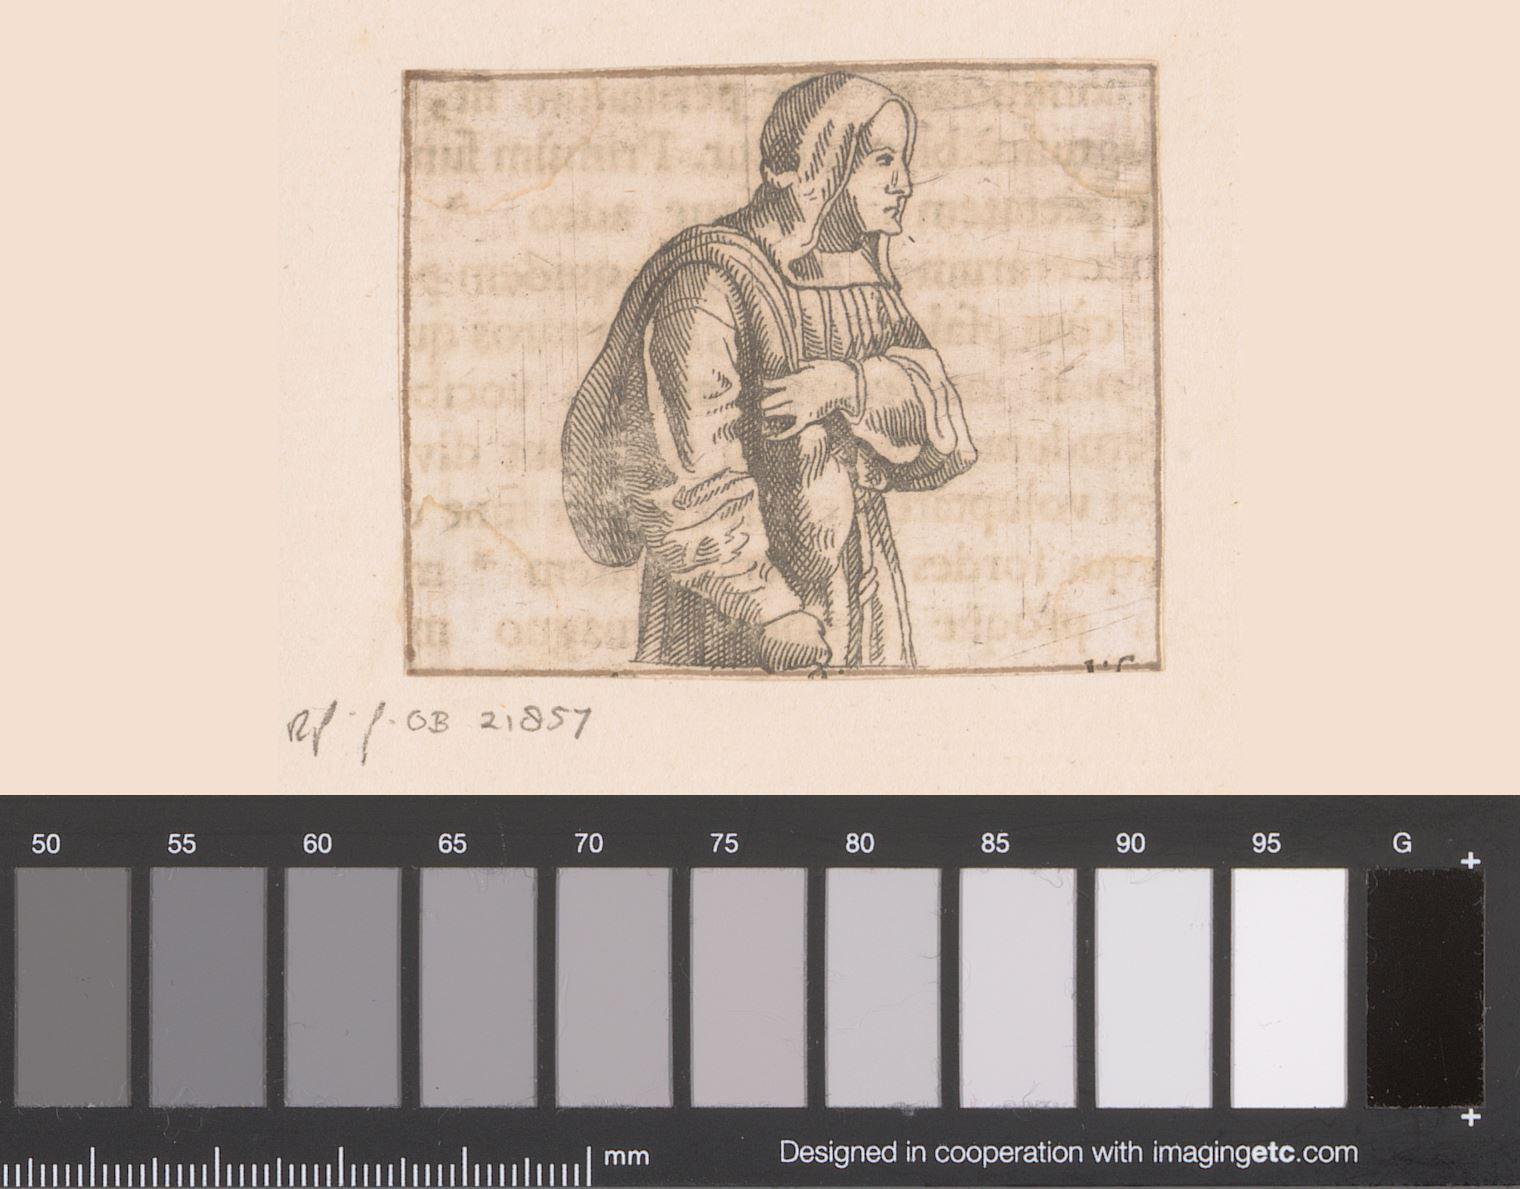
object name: print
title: Bedelmonnik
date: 1516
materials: paper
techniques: etching, letterpress printing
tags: rotterdam, desiderius erasmus, monastic orders, monastic life ~ roman catholic church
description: Prent afkomstig uit: Erasmus, Desiderius. Morias enkomion (...). Bazel: Johann Rudolf Genath, 1676. De prenten hierin zijn naar tekeningen die Hans en Ambrosius Holbein maakten voor de theoloog Oswald Myconius in diens uitgave van de Moriae encomium (Lof der Zotheid) van 1516.